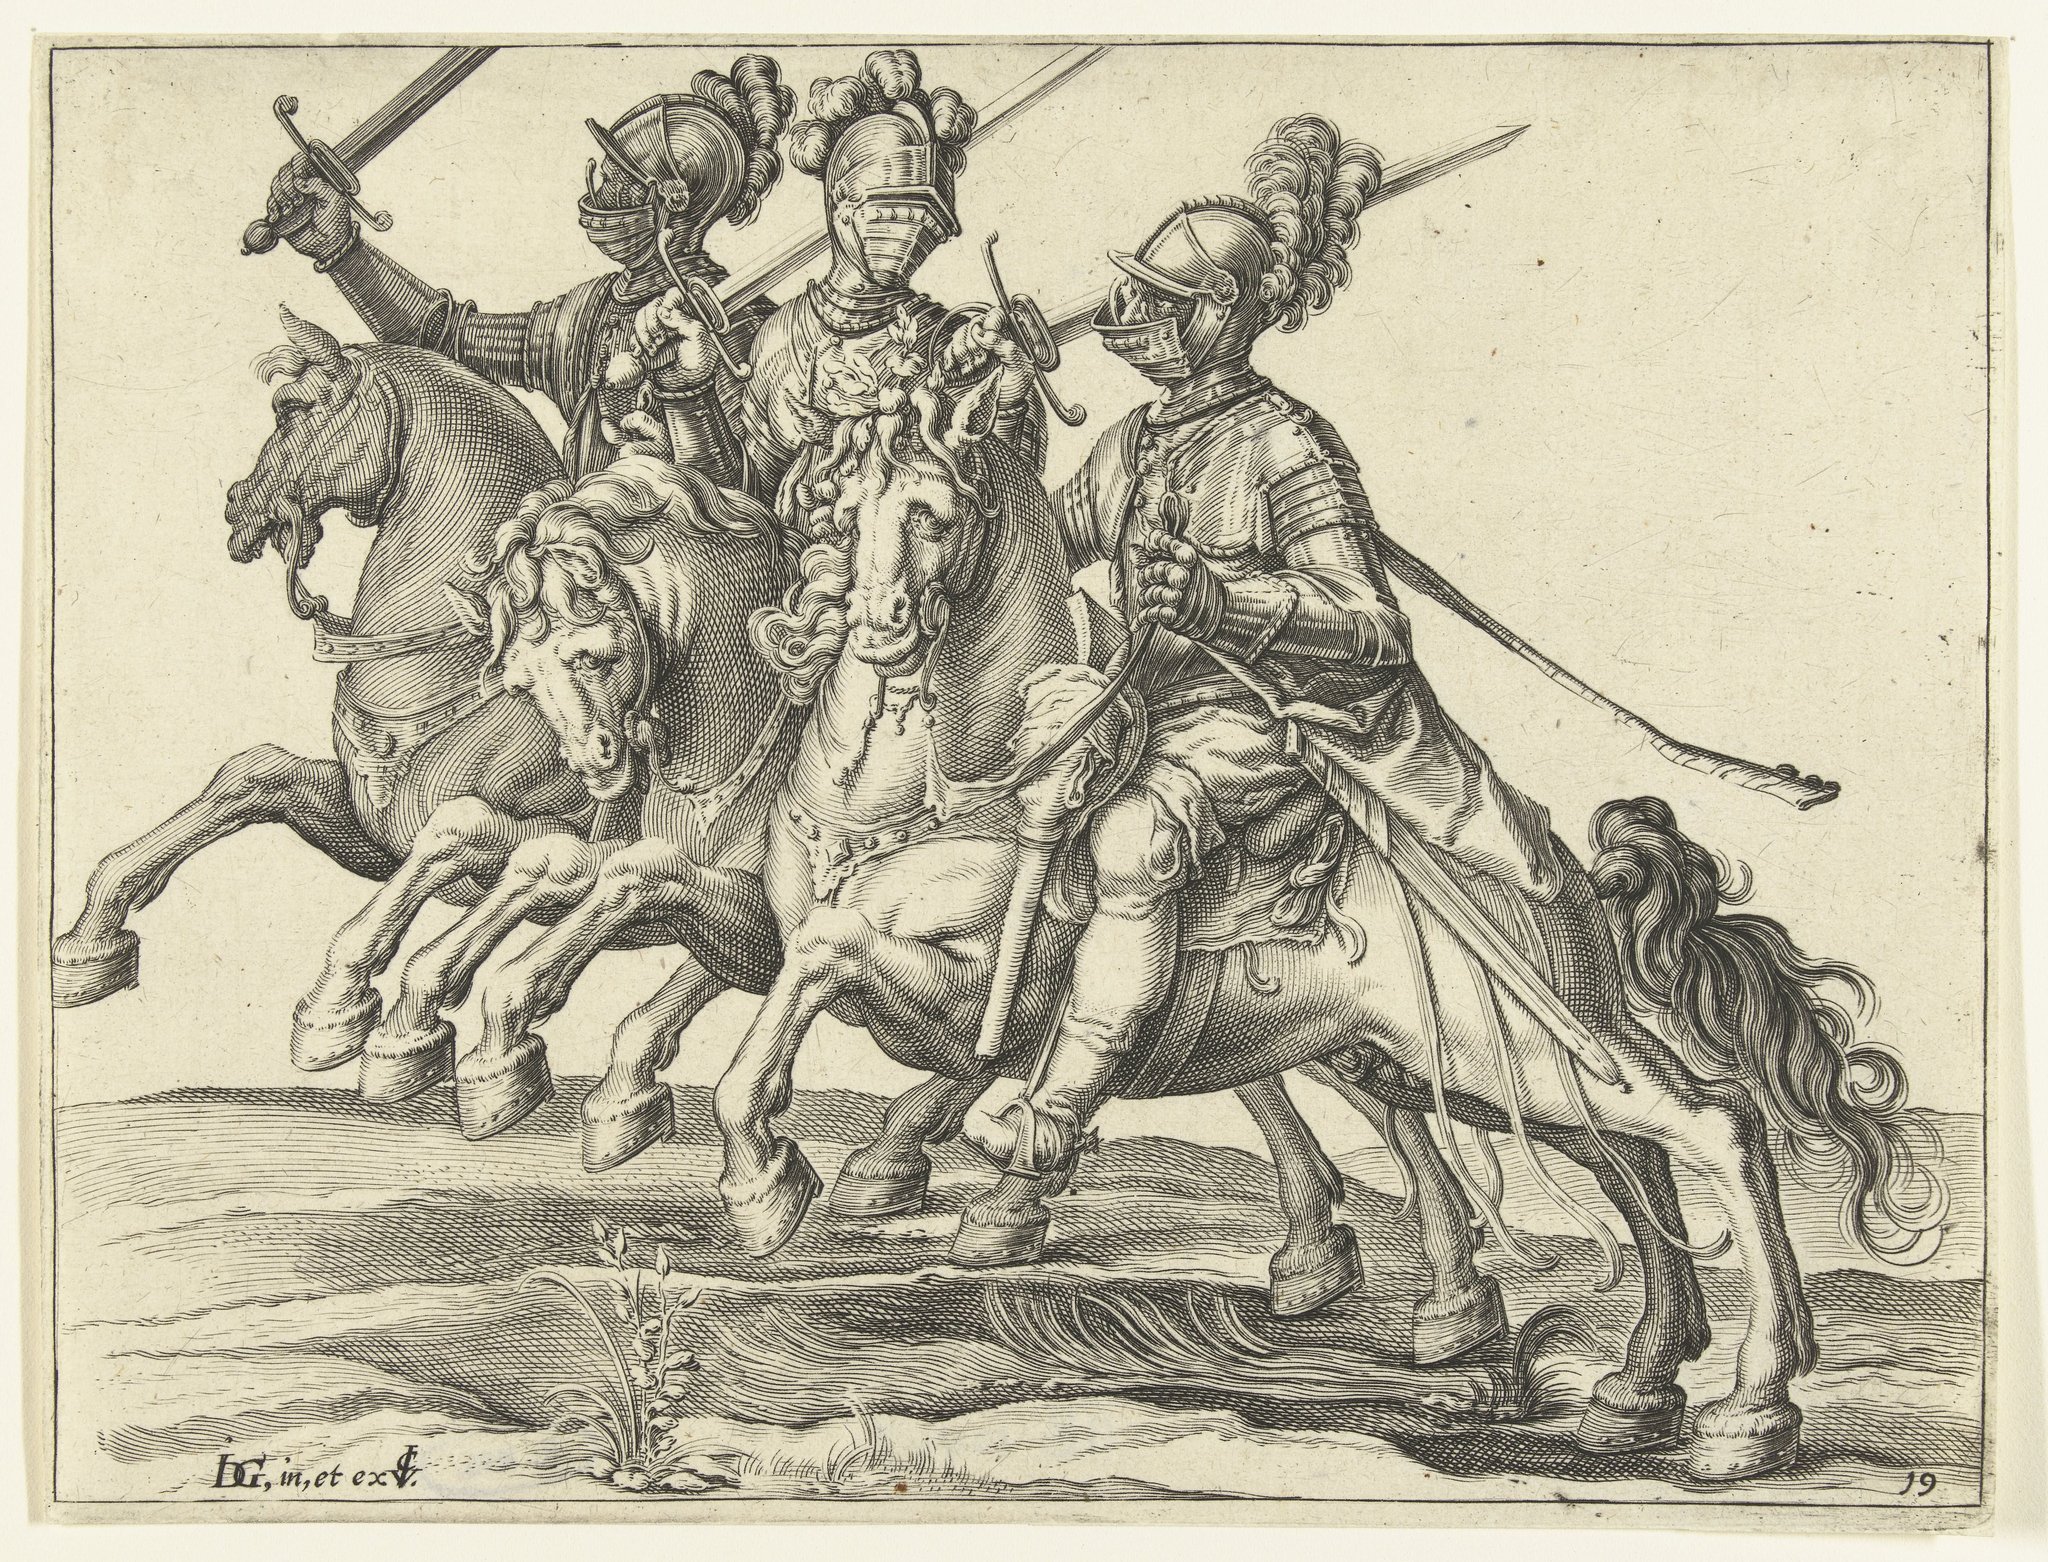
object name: print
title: De ruiterschool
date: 1599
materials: paper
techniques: engraving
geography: leiden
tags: hacking and thrusting weapons: sword, warfare; military affairs (+ cavalry, horsemen)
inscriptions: collector's mark: Lugt 2228a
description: Drie geharnaste mannen te paard, naar links rijdend, elk met een geheven zwaard in de rechterhand. Deze prent is onderdeel van een serie van 22 genummerde prenten: een titelprent, 20 prenten waarop één of enkele verschillende typen (meest geharnaste) ruiters zijn weergegeven, en een prent met een ruitergevecht.